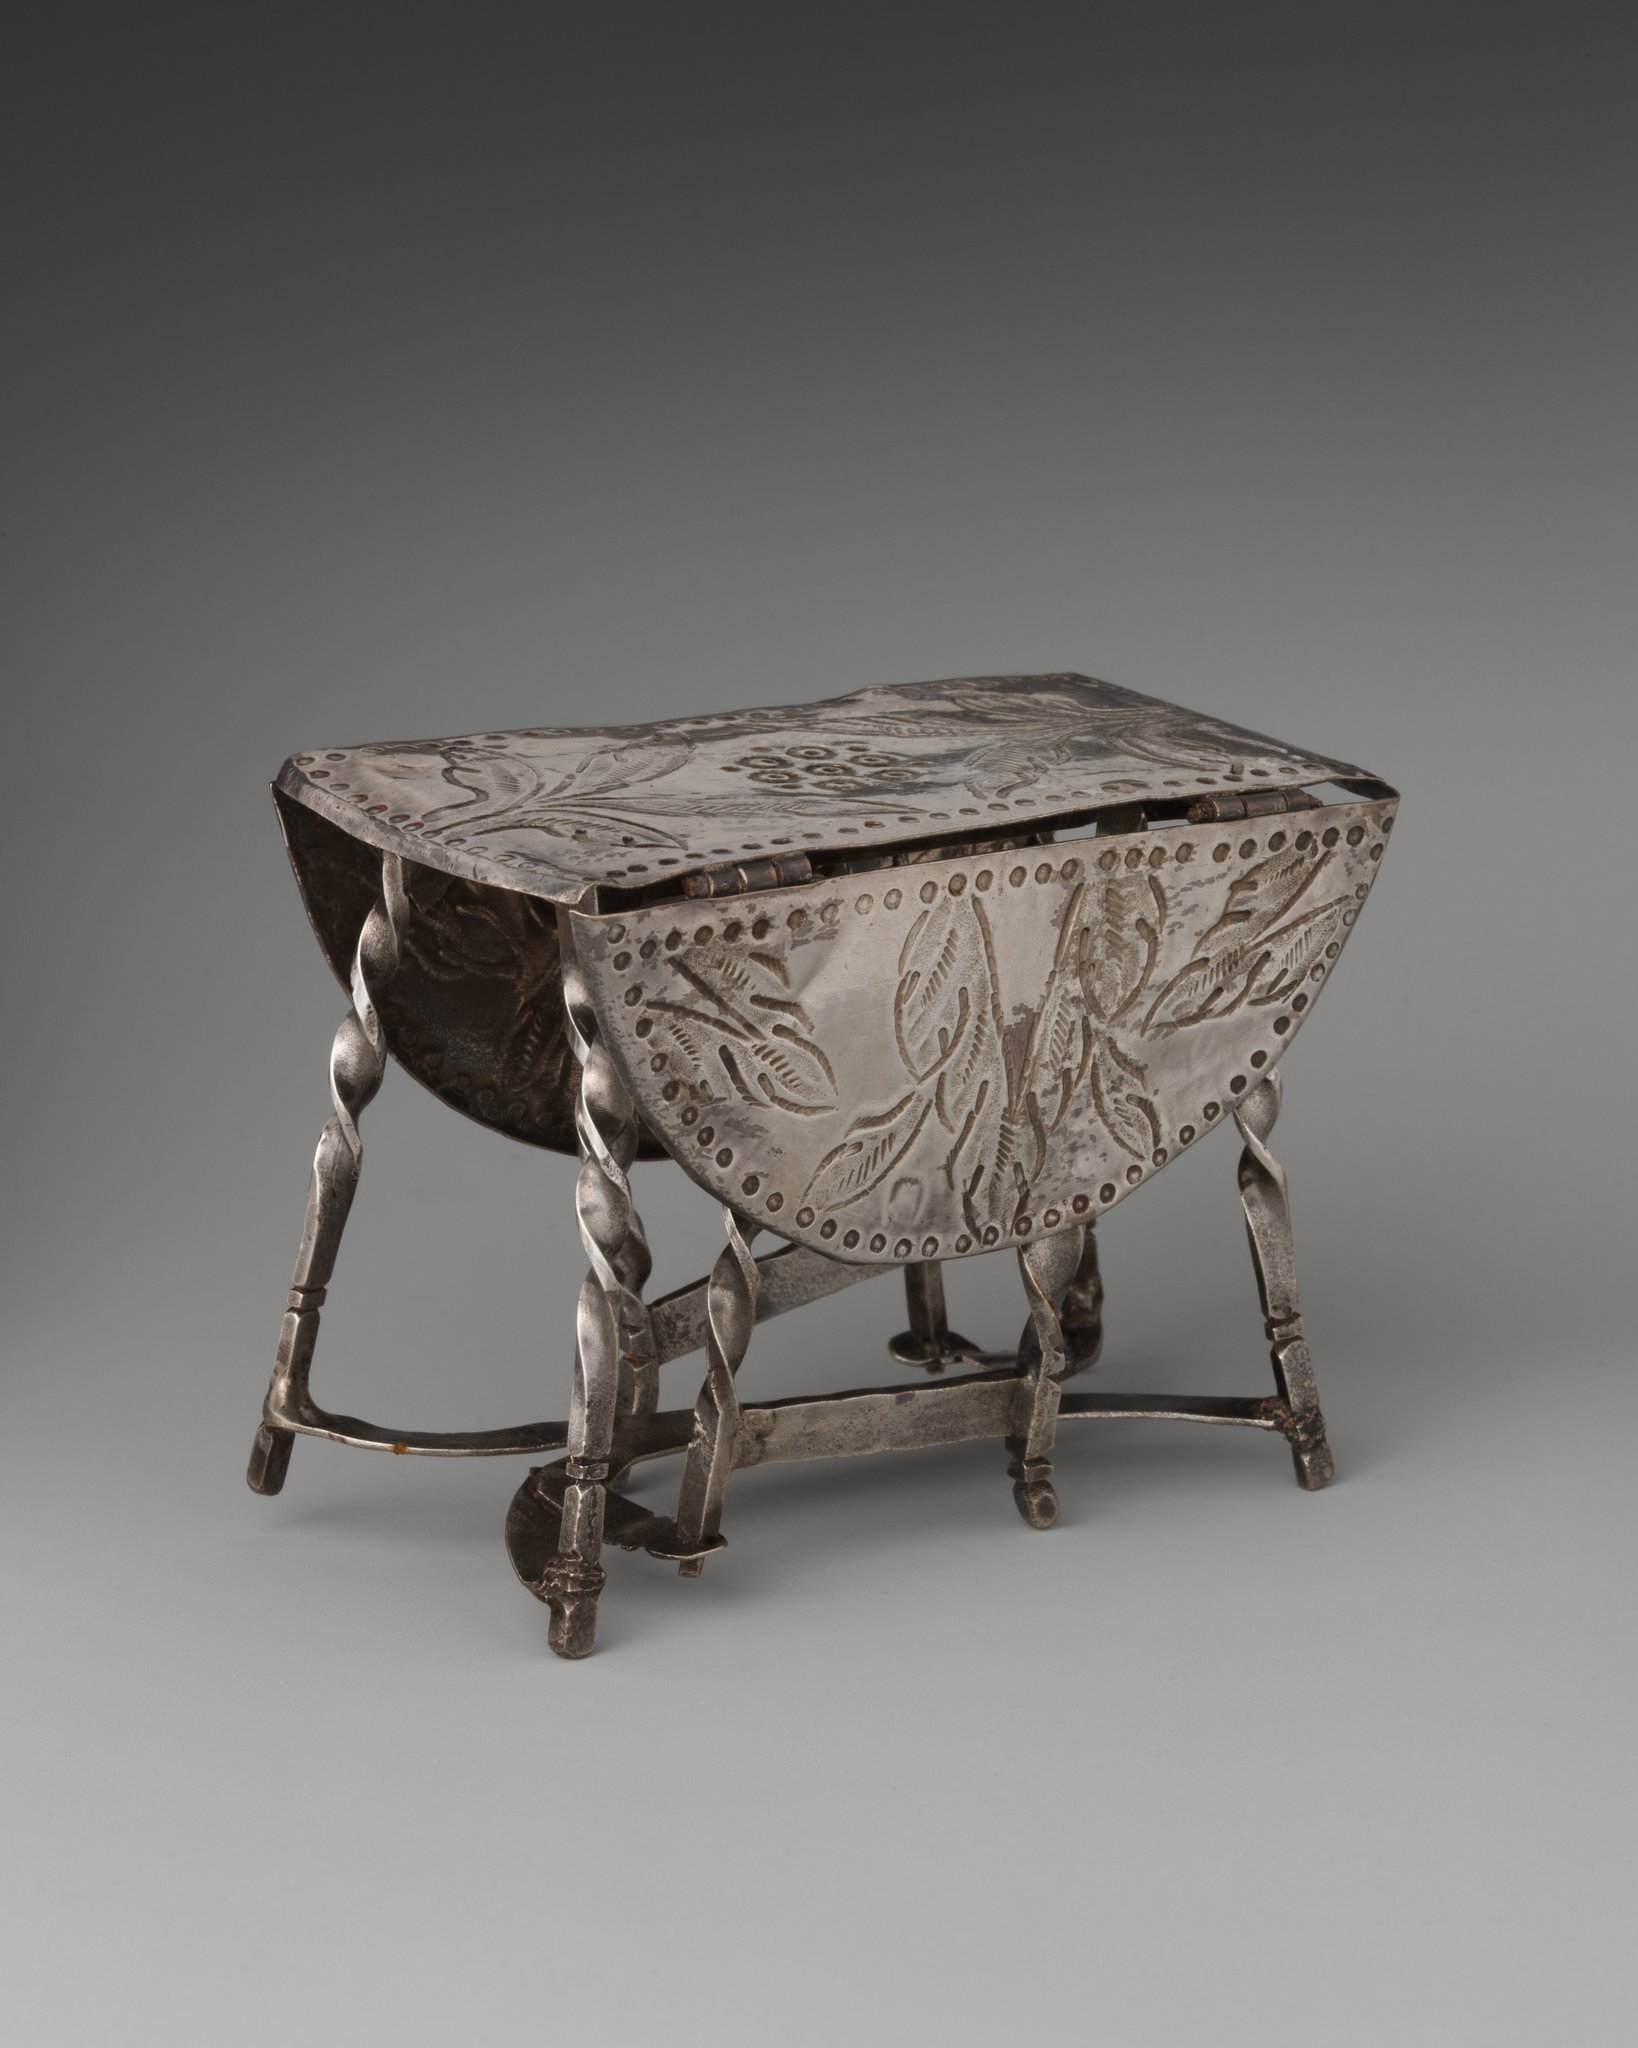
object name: gateleg table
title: Miniature gateleg table (one of a pair)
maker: george manjoy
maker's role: maker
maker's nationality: british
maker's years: 1685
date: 1699-1700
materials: silver